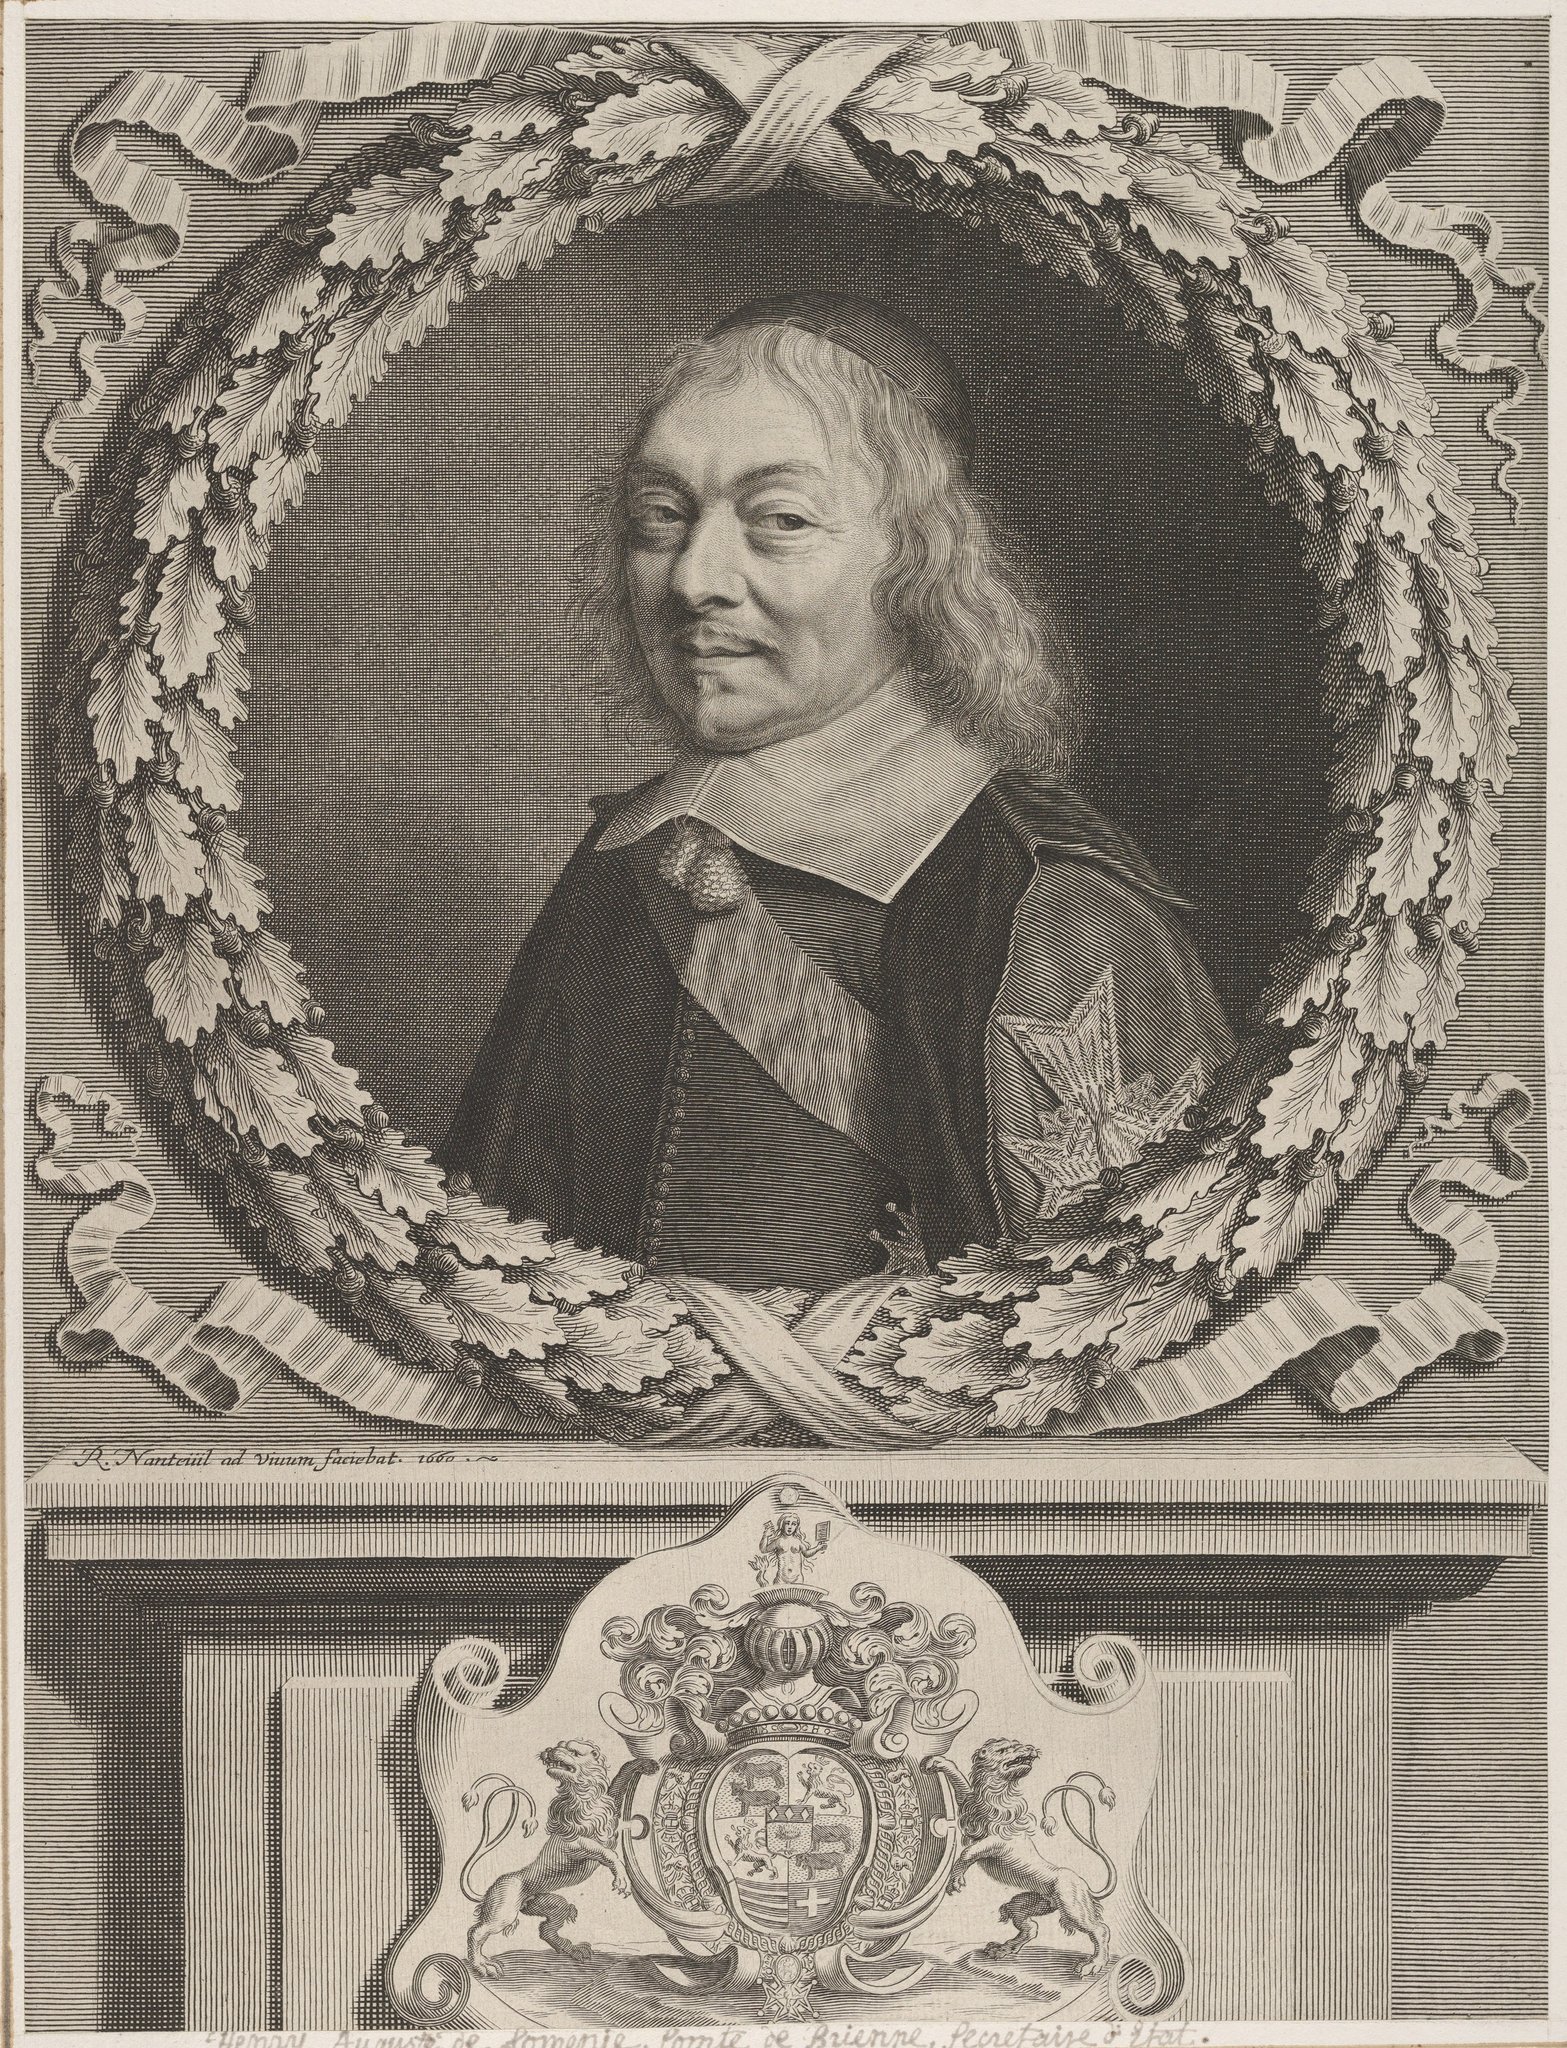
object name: print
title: Henri-Auguste de Loménie, comte de Brienne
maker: robert nanteuil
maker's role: artist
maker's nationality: french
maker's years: 1623-1678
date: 1660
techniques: engraving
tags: men,portraits,coat of arms